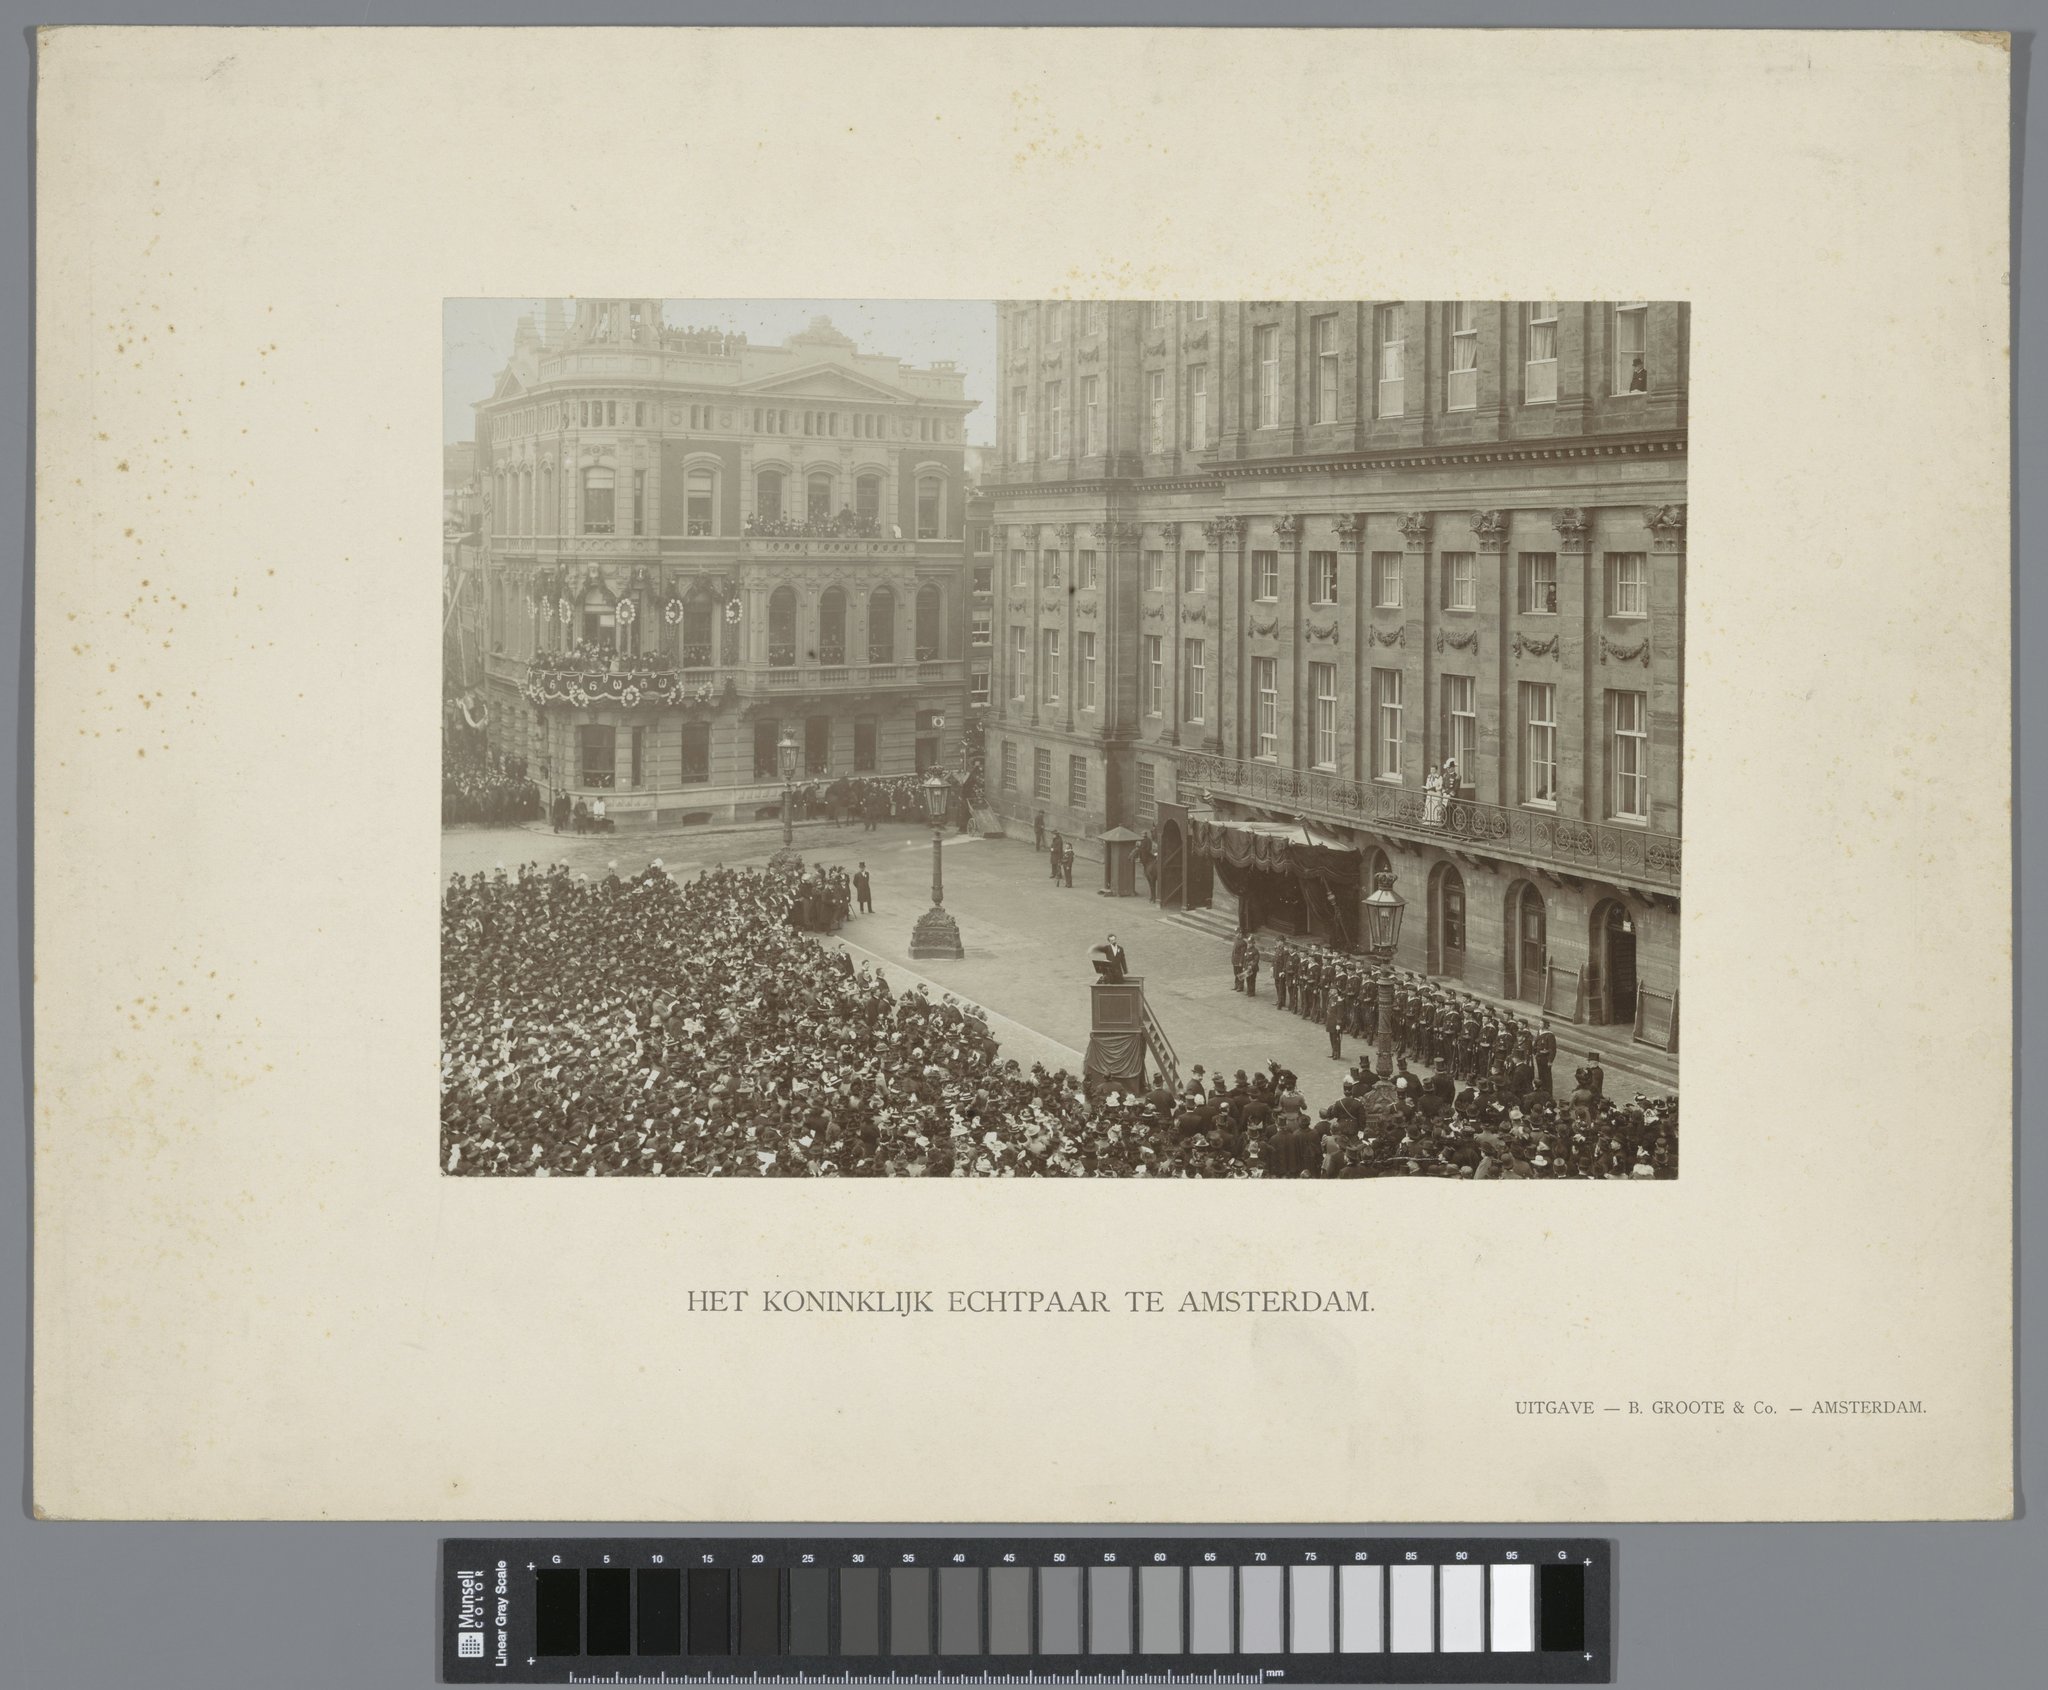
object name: photograph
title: Het koninklijk echtpaar te Amsterdam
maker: barend groote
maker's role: fotograaf, fotohandel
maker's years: 1862-1946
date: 1901-1910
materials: cardboard, photographic support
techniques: albumen print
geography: amsterdam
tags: wilhelmina of the netherlands, the hague, hendrik (prins der nederlanden (1876-1934))